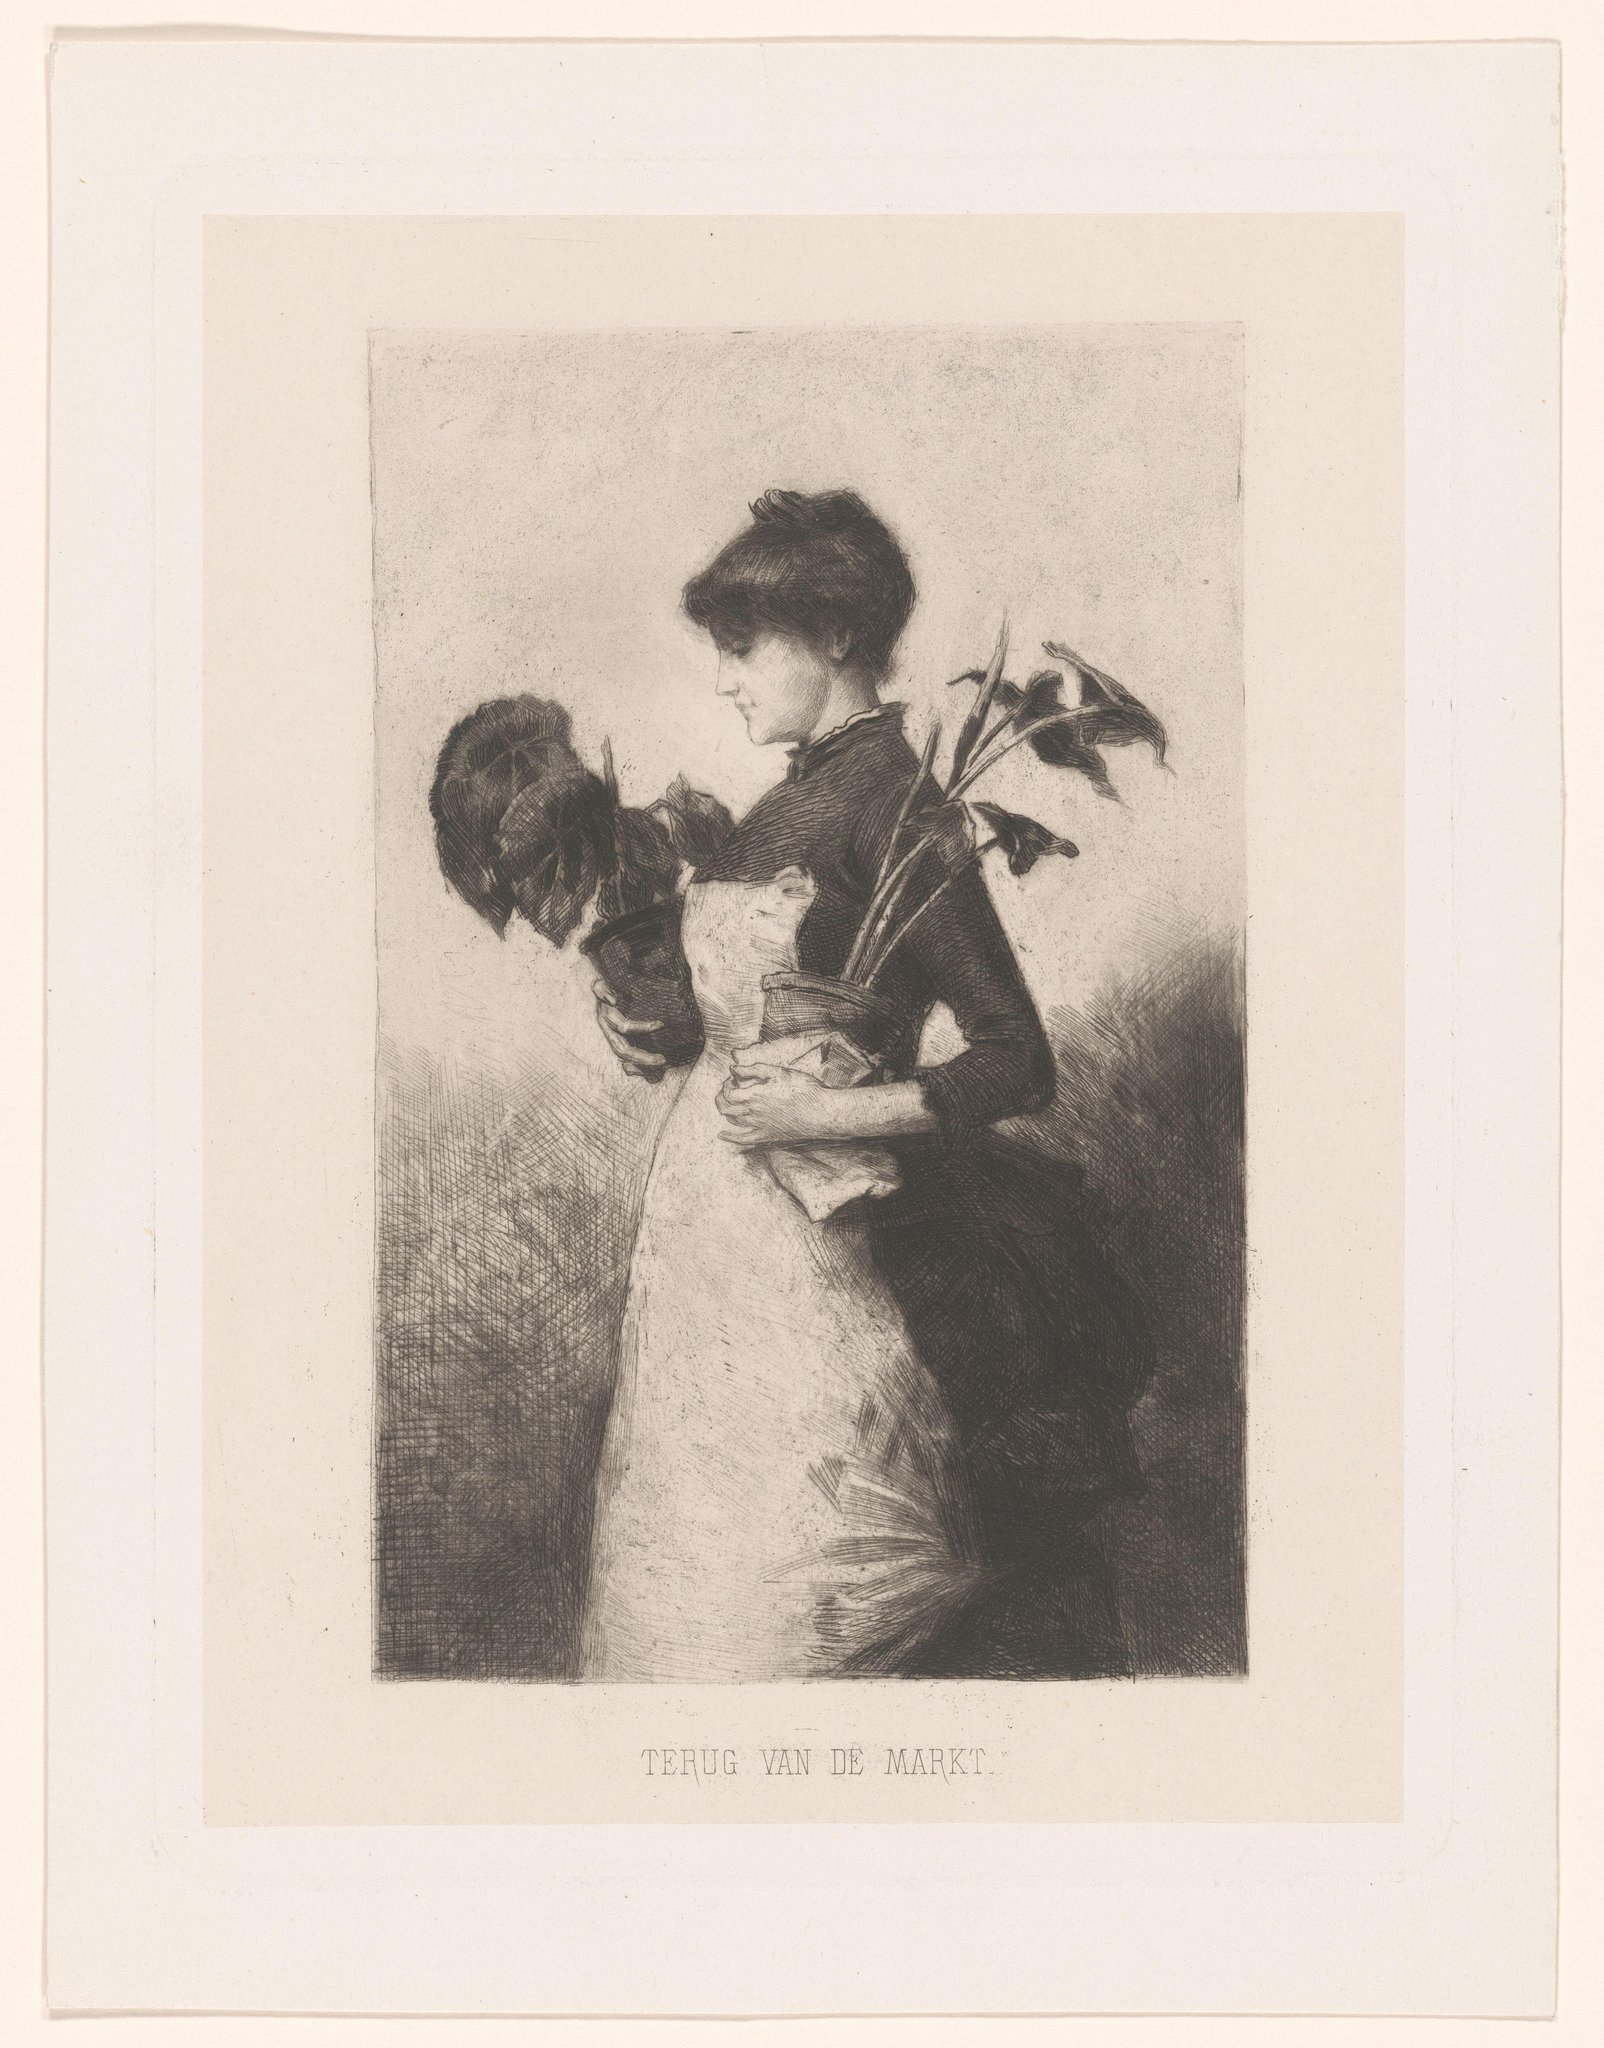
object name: print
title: Vrouw met twee planten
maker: ernst witkamp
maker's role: draughtsman, print maker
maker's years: 1854-1897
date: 1886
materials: paper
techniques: drypoint, etching, intaglio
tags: adult woman, market, potted plants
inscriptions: inscription: ‘distel 1886’, collector's mark: Lugt 2228